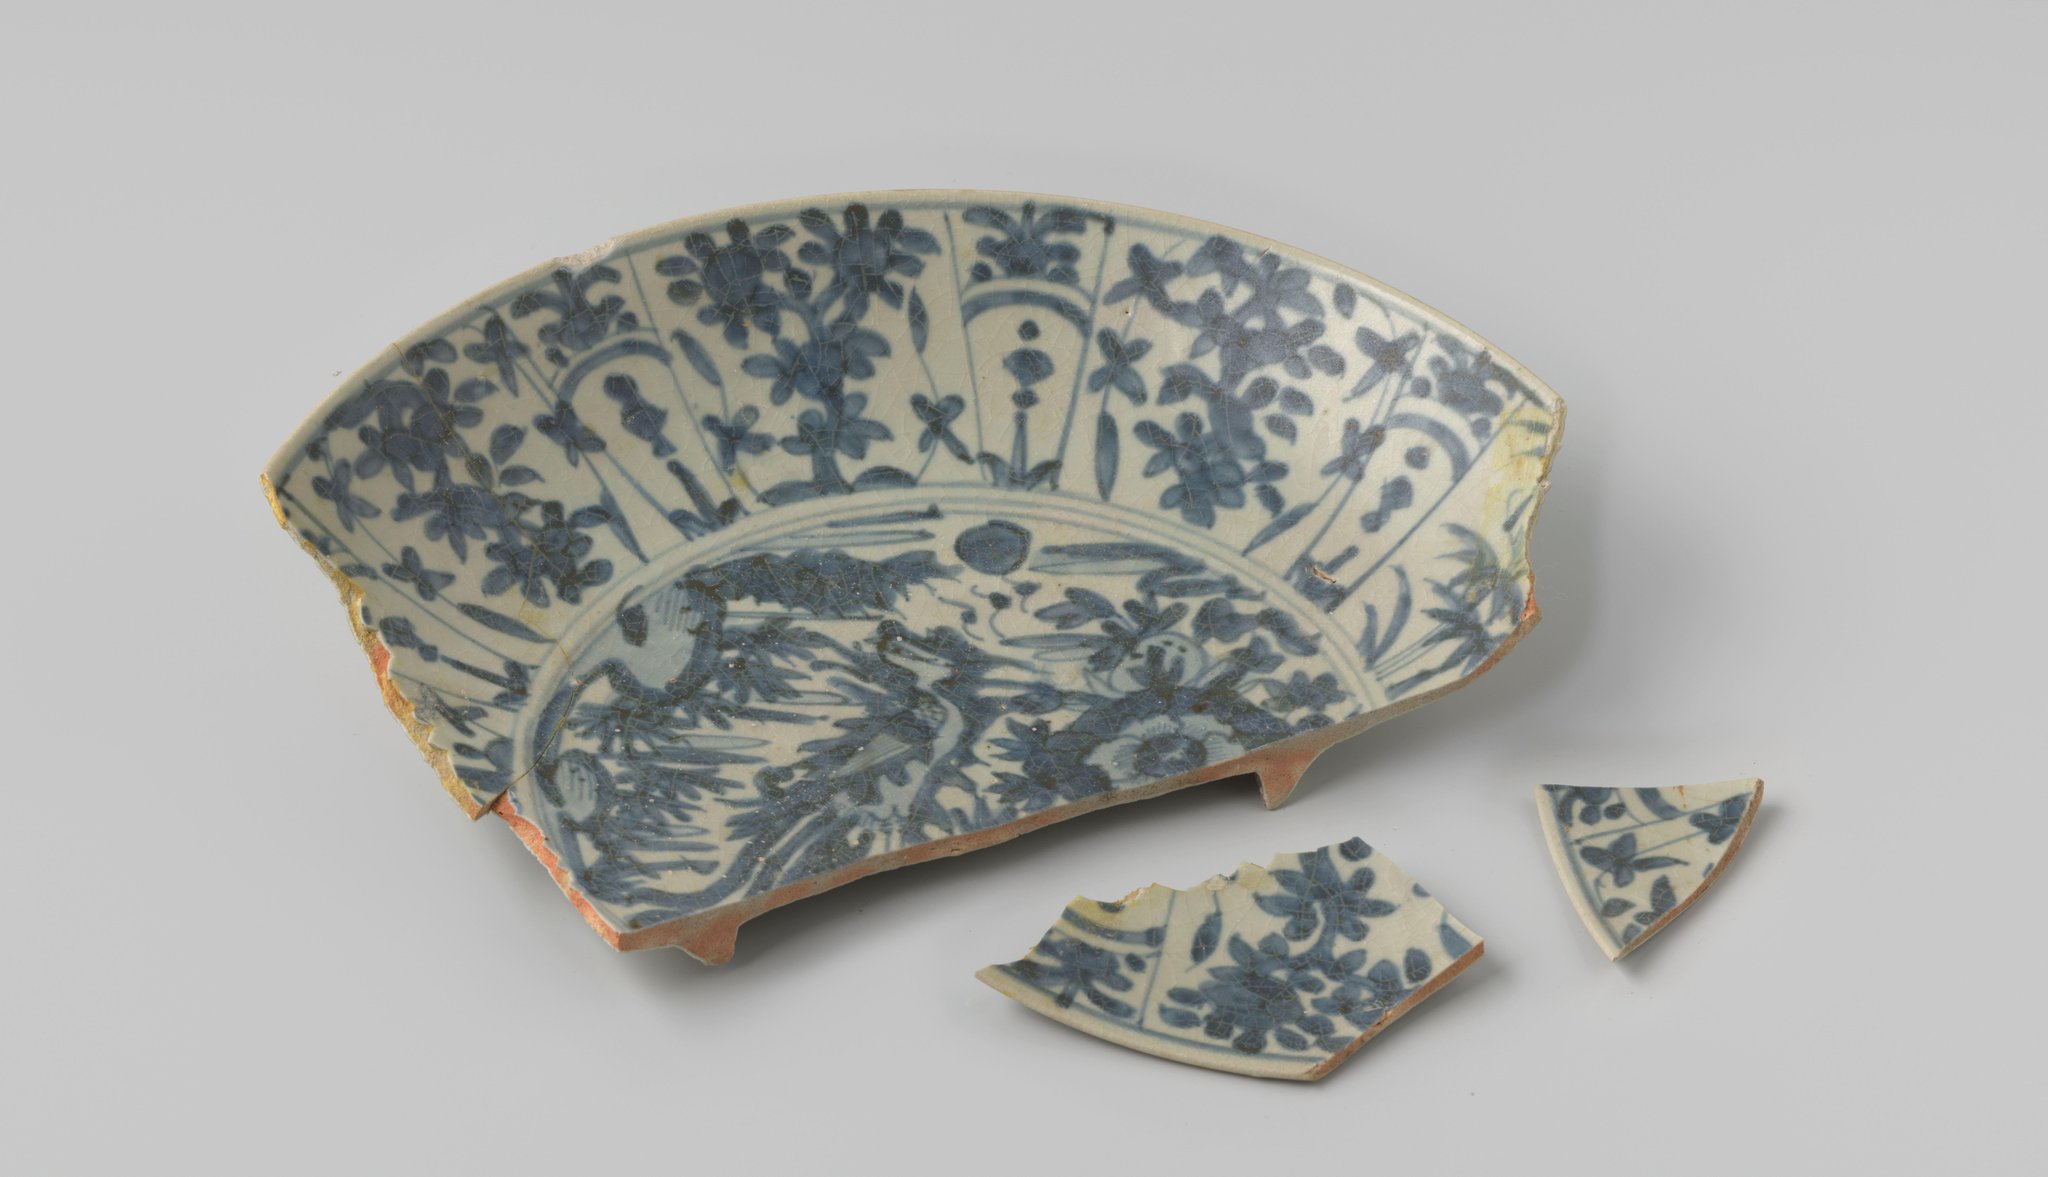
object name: plate dish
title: Scherven van een bord uit V.O.C.-schip de 'Witte Leeuw'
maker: Anonymous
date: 1613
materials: porcelain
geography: shantou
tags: verenigde oostindische compagnie, sint-helena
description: A dish. The bottom is completely glazed, coarse sand grains cover the footrim. In the centre a phoenix standing looking to the left where there is rocks, water, bamboo and grasses; on the right a peony tree. The broad panels contain a stem with three peaches, twice a spray of bamboo. The narrow panels have a row of dots with a peach on top. On the outside an elongated spray with a peach.